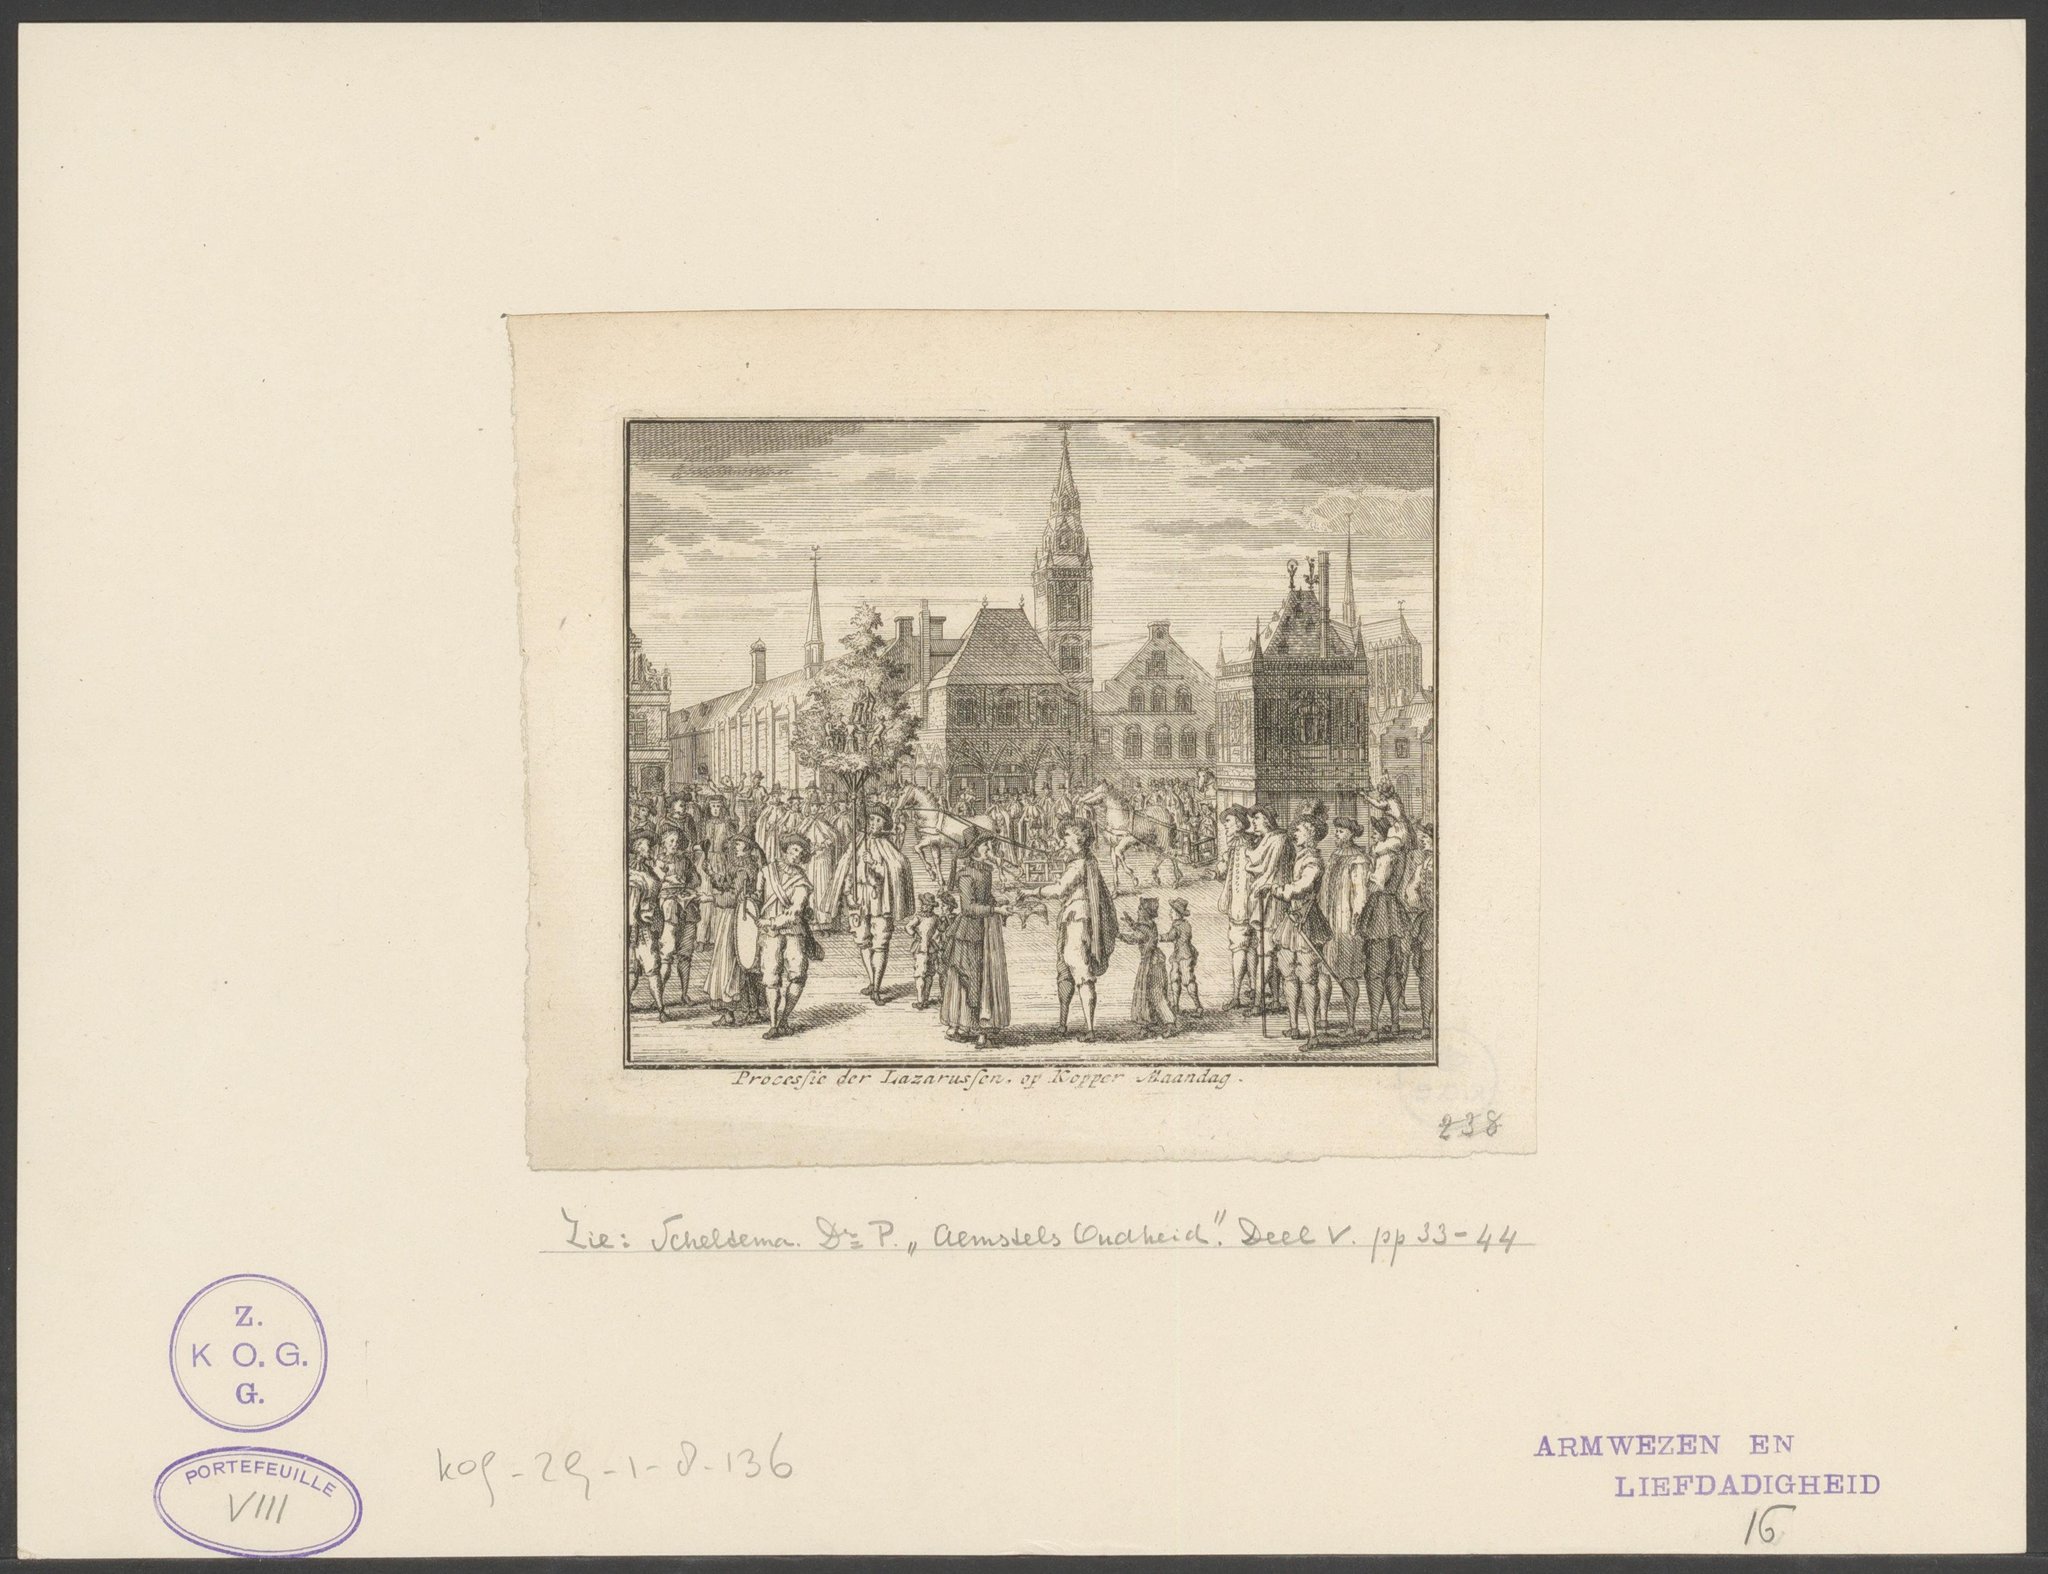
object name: book illustration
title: Leprozenoptocht op Koppermaandag te Amsterdam, 1604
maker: Anonymous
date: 1792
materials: paper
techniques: engraving, etching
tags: 'blue monday', public welfare, leper's procession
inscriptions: collector's mark:, collector's mark: Lugt 1641, collector's mark: Lugt 1641a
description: De jaarlijkse optocht van de gilden op Koppermaandag (de eerste maandag na Driekoningen) te Amsterdam, 1604. Optocht en feestelijkheden van de gilden op de Dam waarbij de leprozen de stad in mogen en waarbij geld voor hen werd ingezameld. In 1604 werd Koppermaandag voor het laatst in Amsterdam gevierd. Onderwerpsrubrieken binnen de Atlas Zeden en Gewoonten: Armwezen en Liefdadigheid.